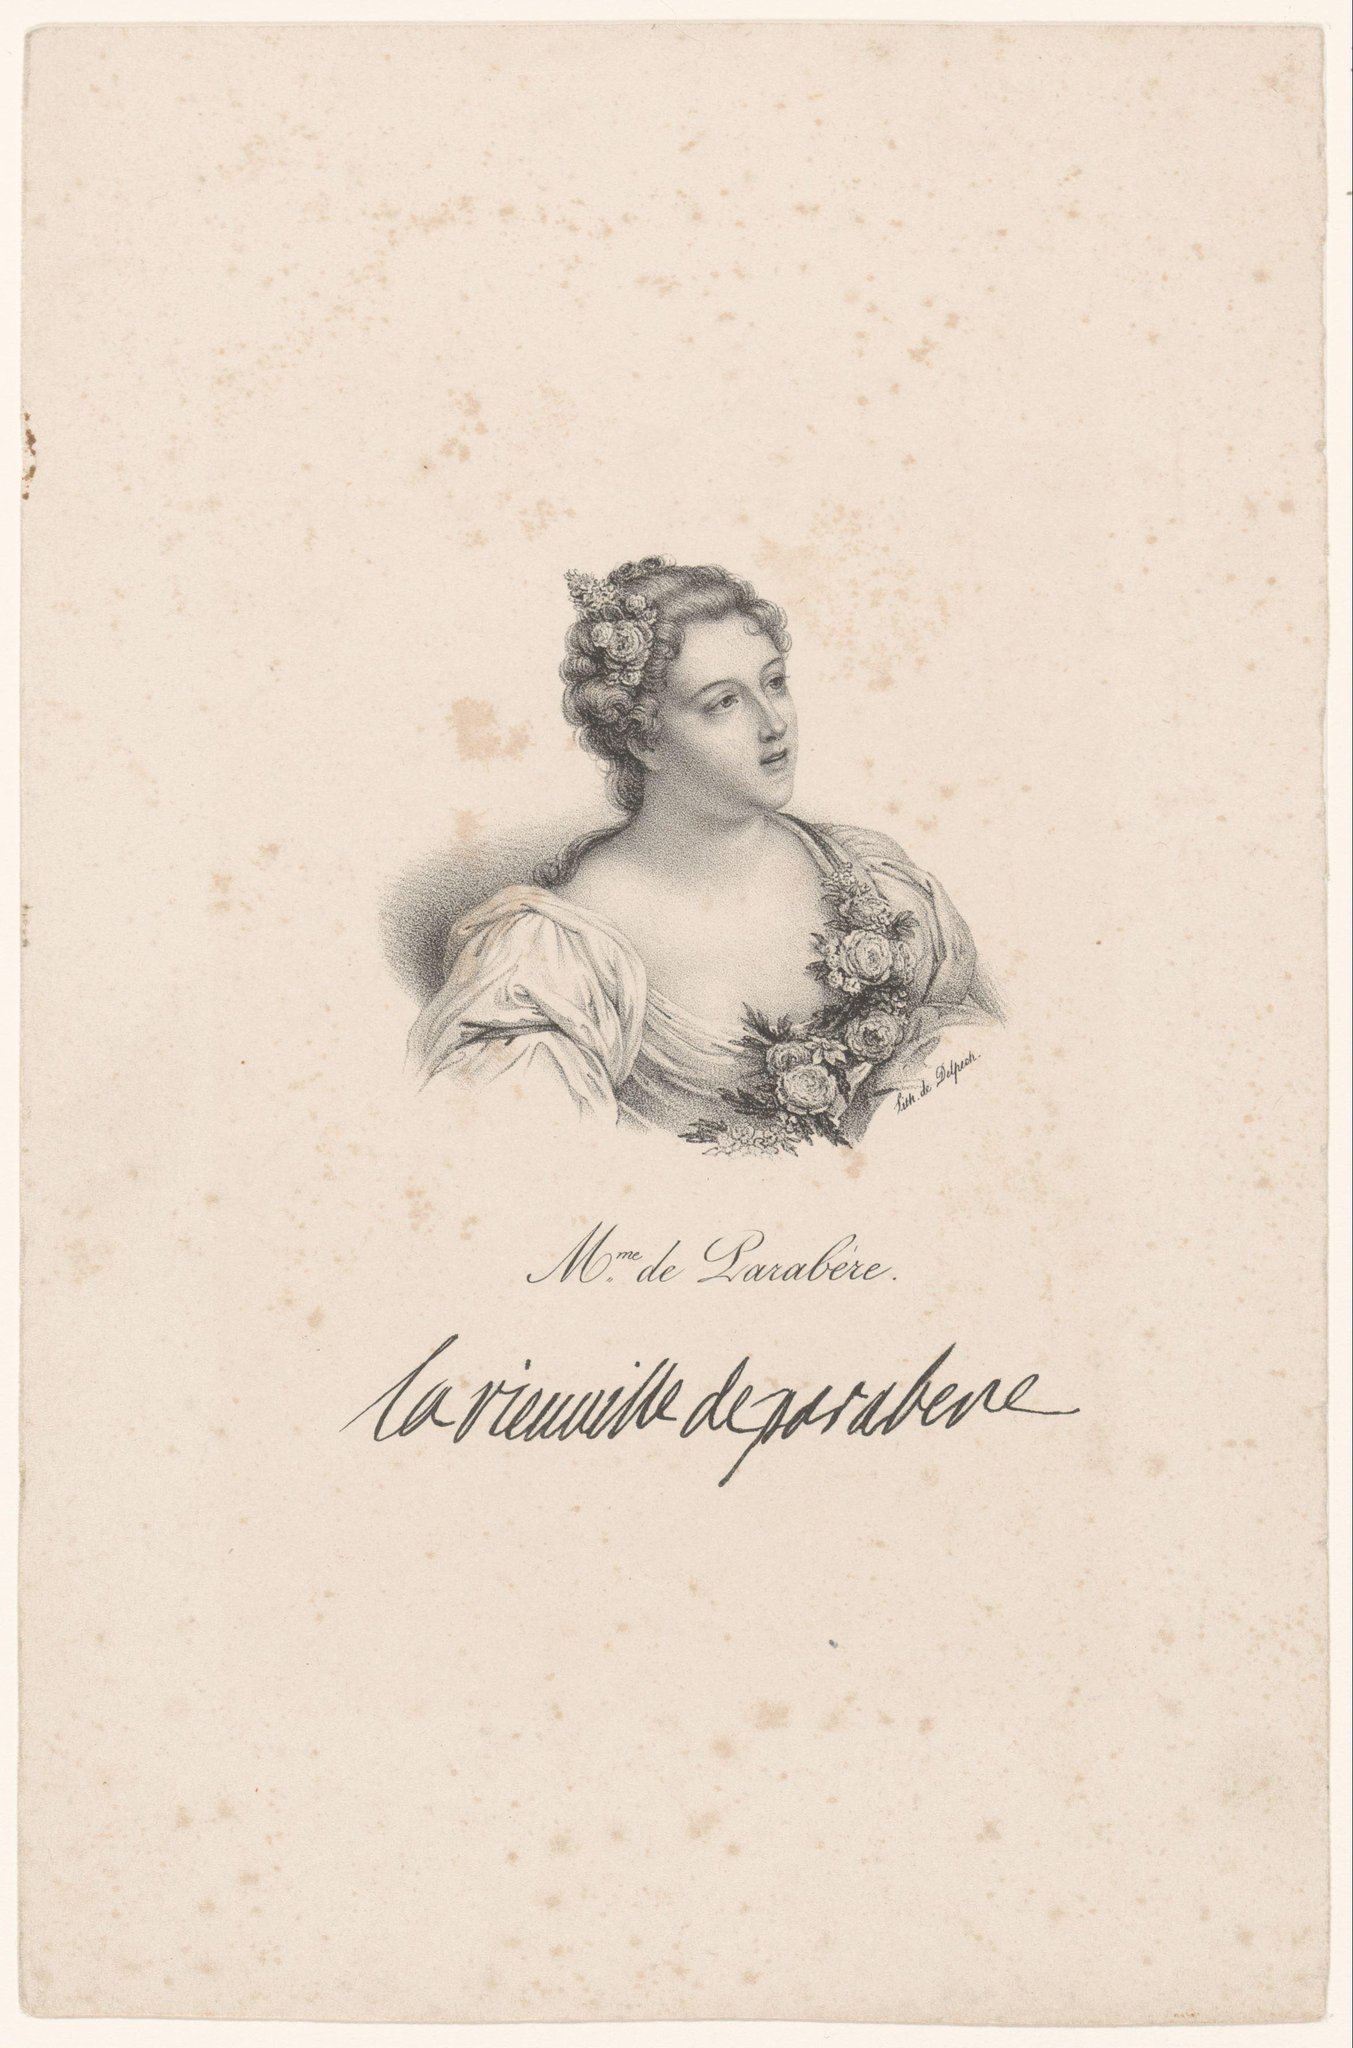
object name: print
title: M.me de Parabère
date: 1818-1842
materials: paper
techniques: lithograph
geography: paris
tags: historical persons